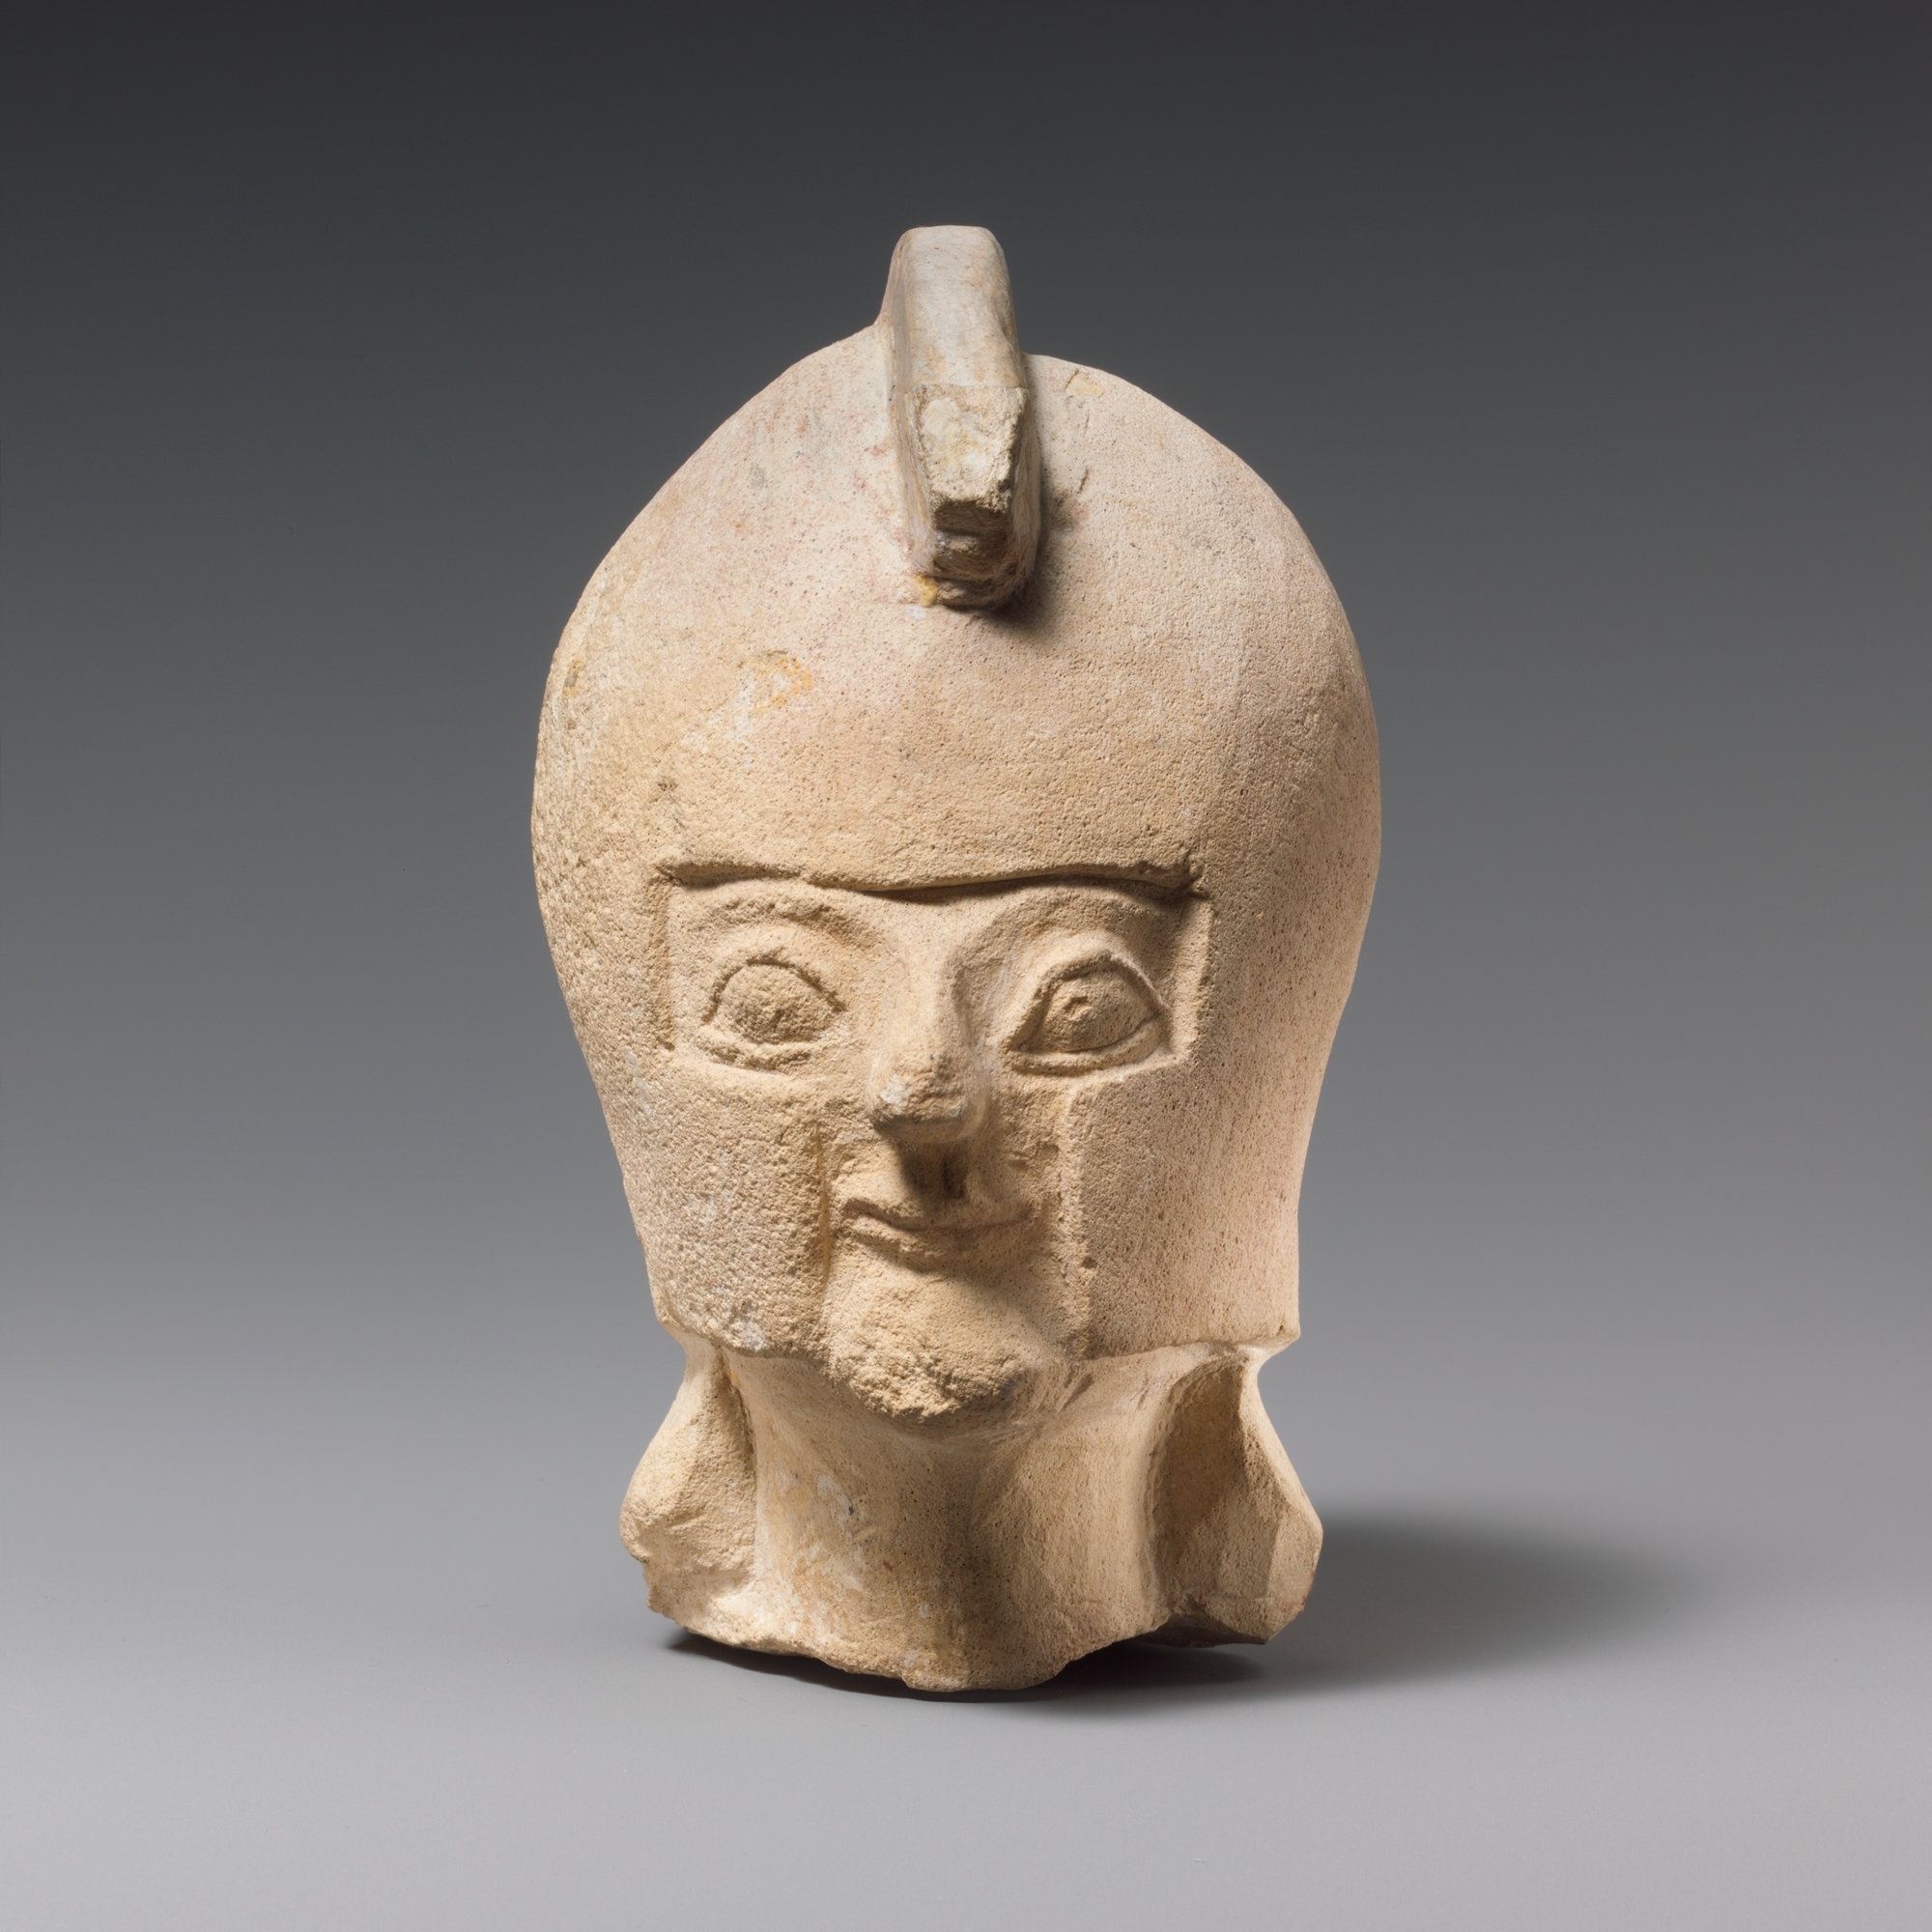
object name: head of a warrior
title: Limestone head of a warrior wearing a crested helmet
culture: cypriot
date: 500-401 BCE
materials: limestone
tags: helmets,heads,warriors